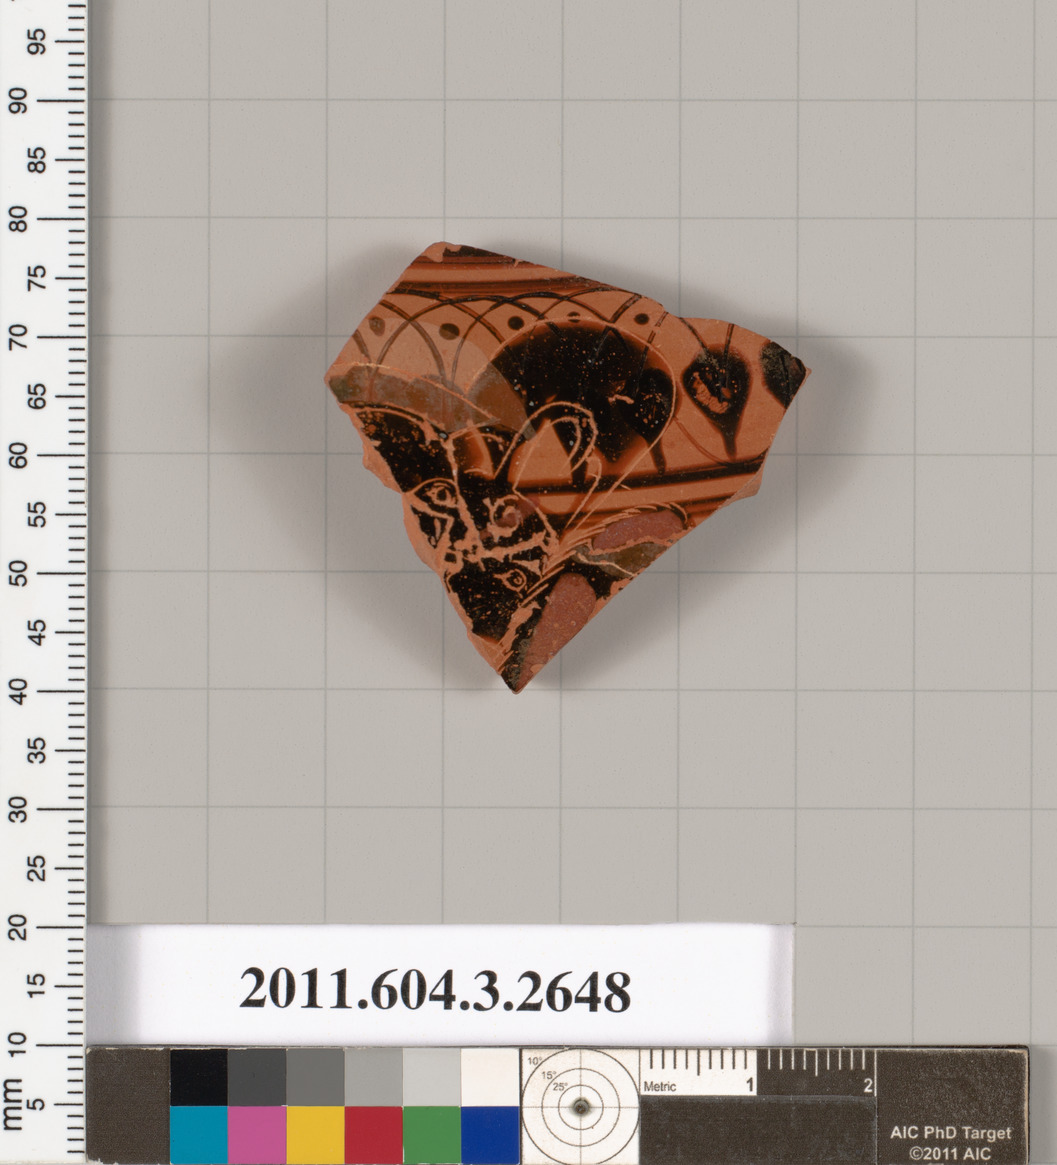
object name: lebes fragment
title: Terracotta fragment of a lebes (deep bowl)?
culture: greek, attic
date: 550-526 BCE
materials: terracotta